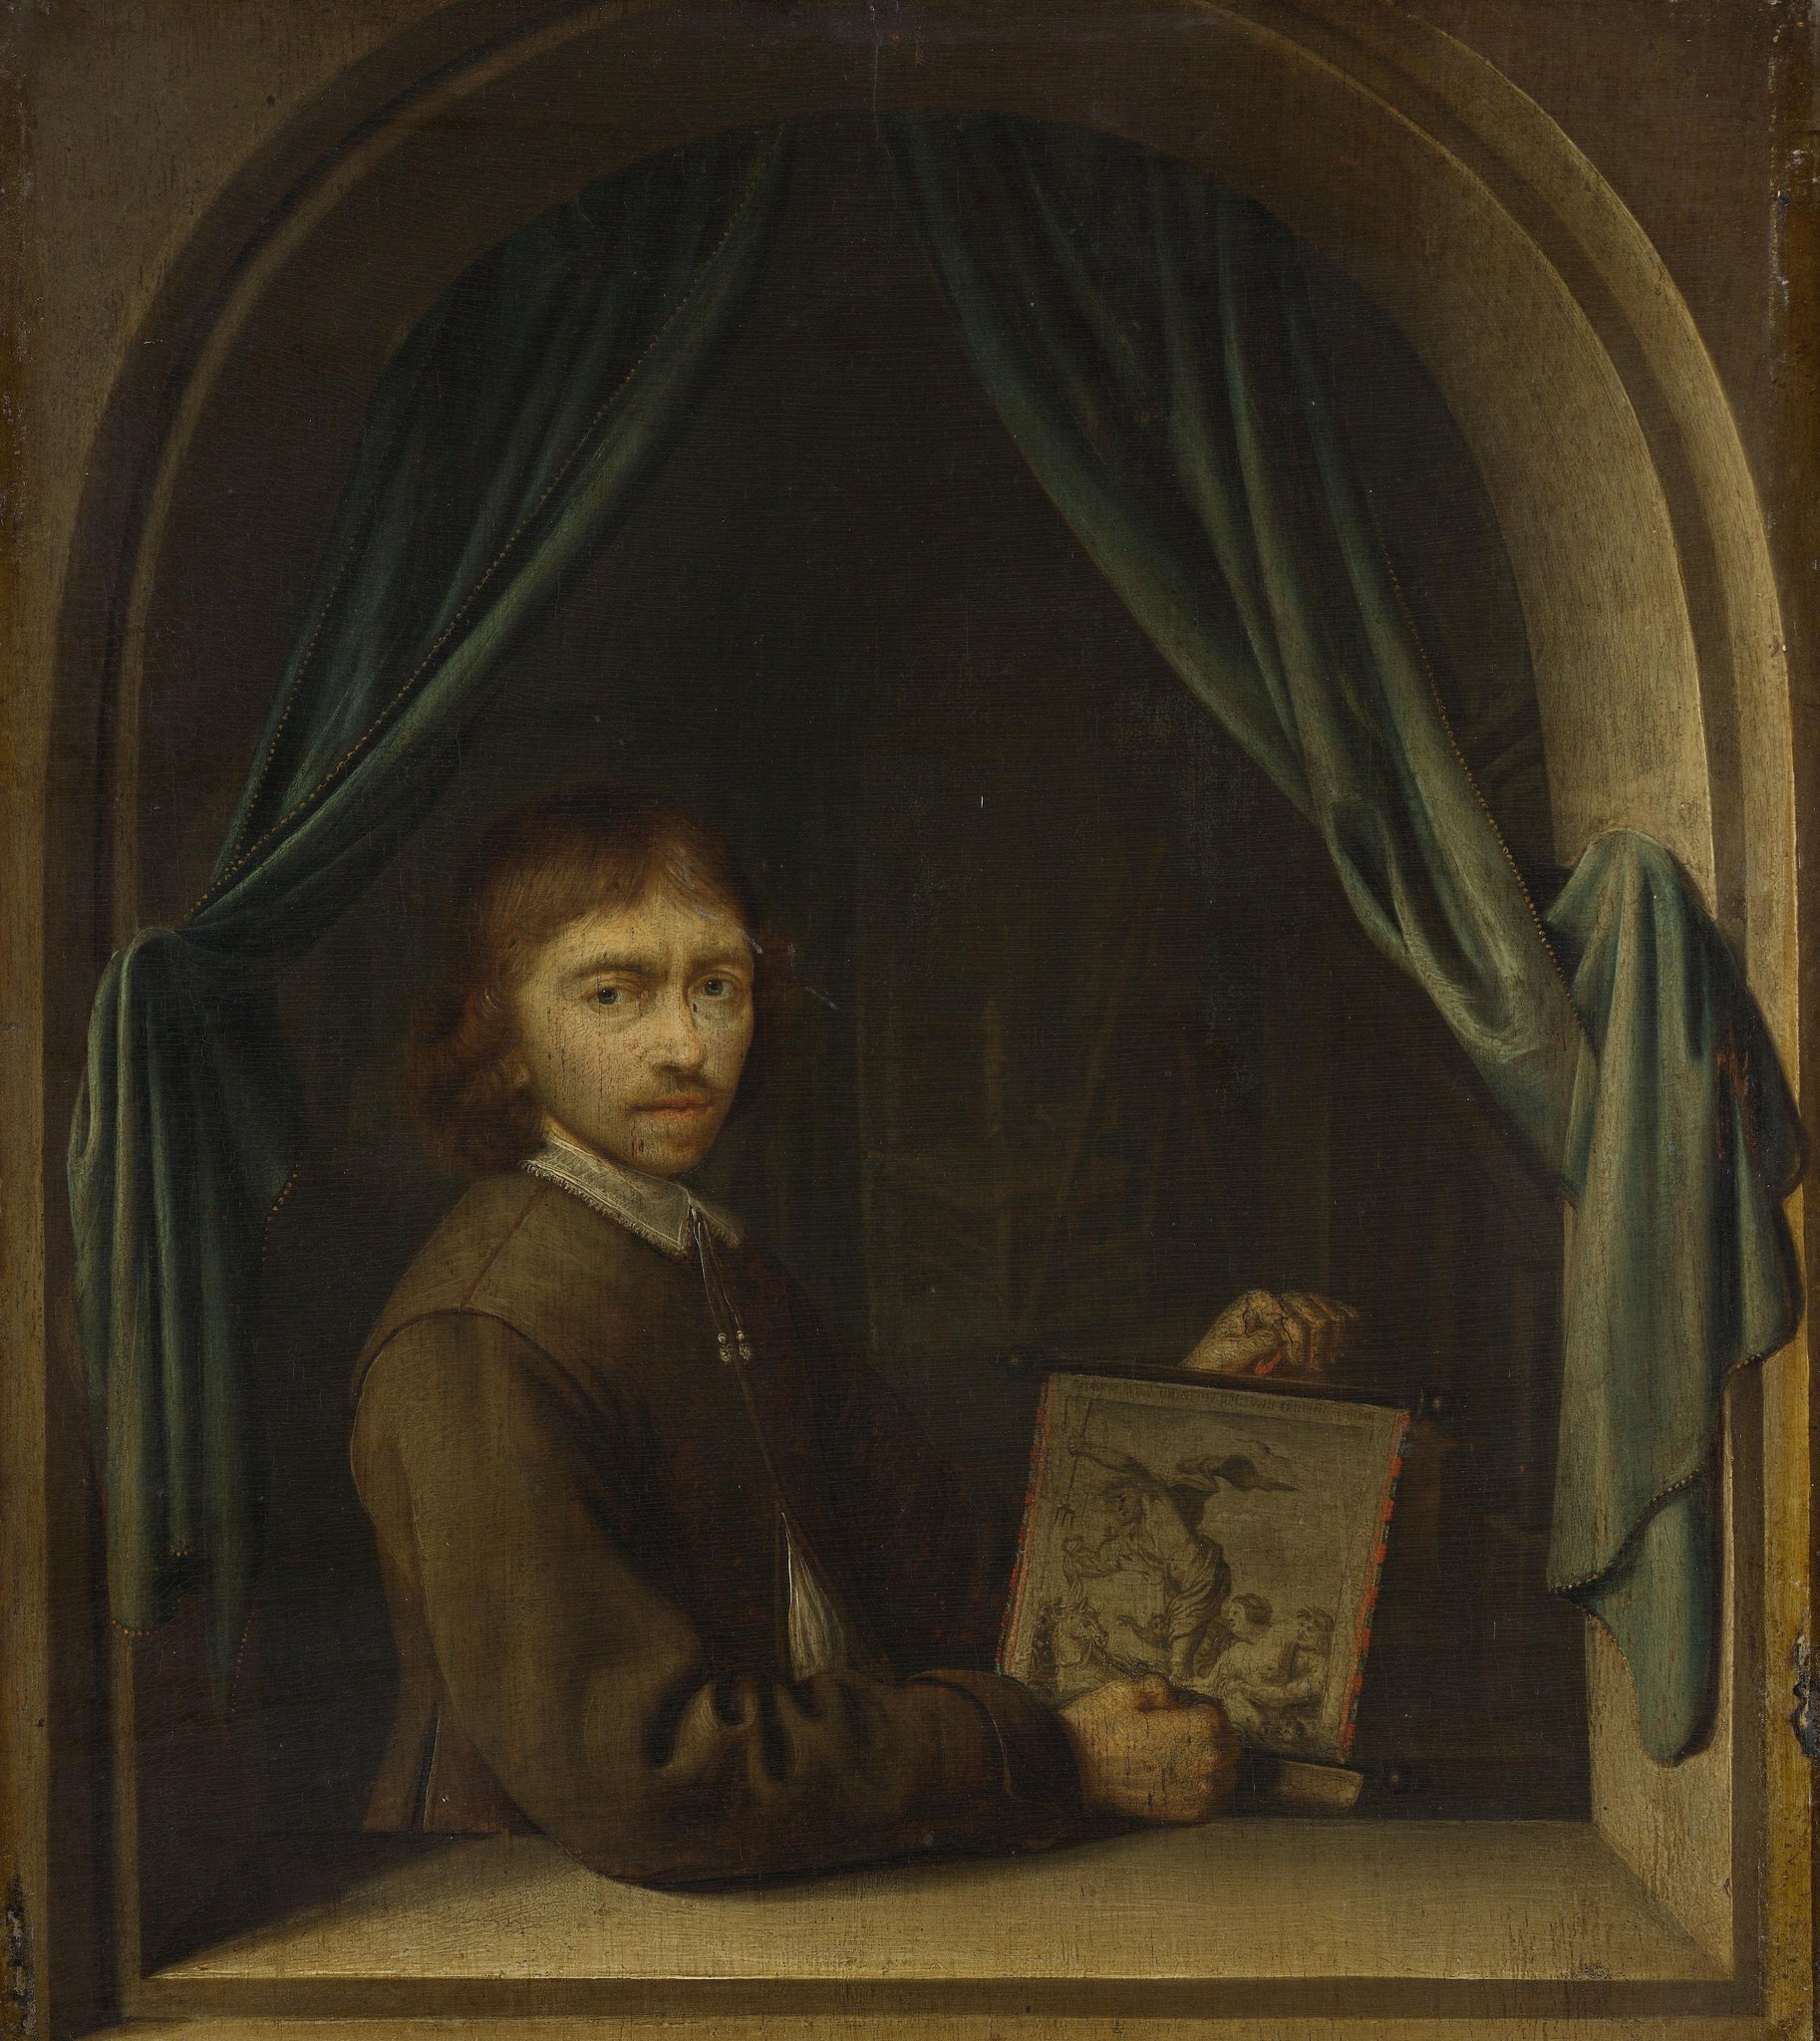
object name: painting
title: Self-Portrait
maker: pieter van egmondt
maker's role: painter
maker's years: 1614-1663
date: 1655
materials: oil, panel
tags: pieter van egmondt, historical persons, portrait, self-portrait of painter, portrait, self-portrait of artist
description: Portret van een schilder. Staande in een boog met een schilderij met een voorstelling van Neptunus in de handen.